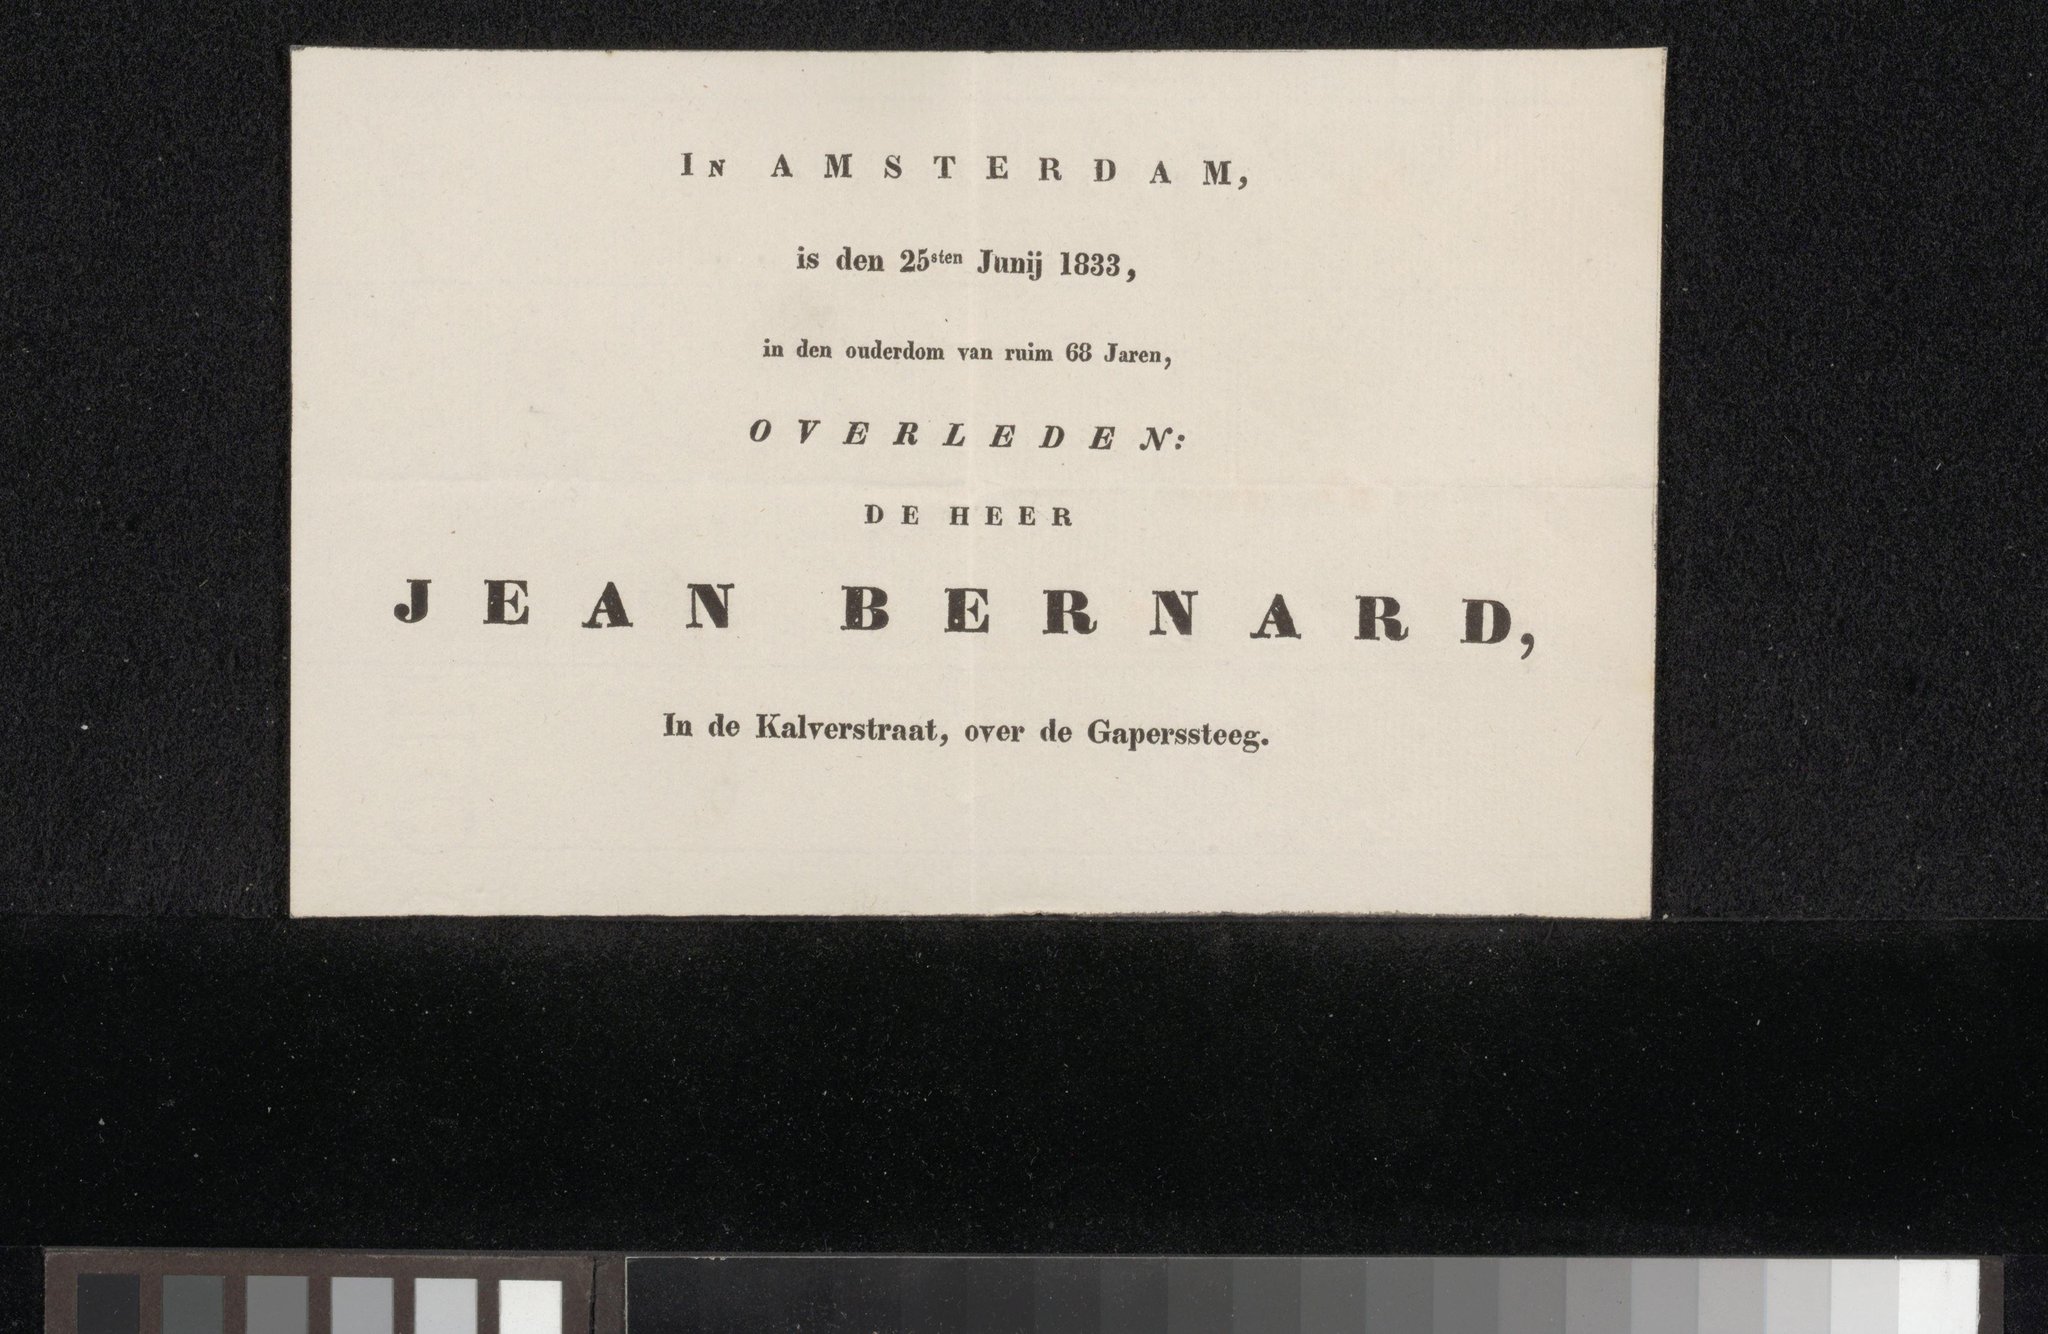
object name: overlijdensbericht, overlijdensadvertentie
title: Overlijdensbericht betreffende Jean Bernard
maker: Anonymous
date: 1833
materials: paper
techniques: printing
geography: amsterdam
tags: amsterdam, print maker, draughtsman, jean bernard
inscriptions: collector's mark: Lugt 2166, watermark